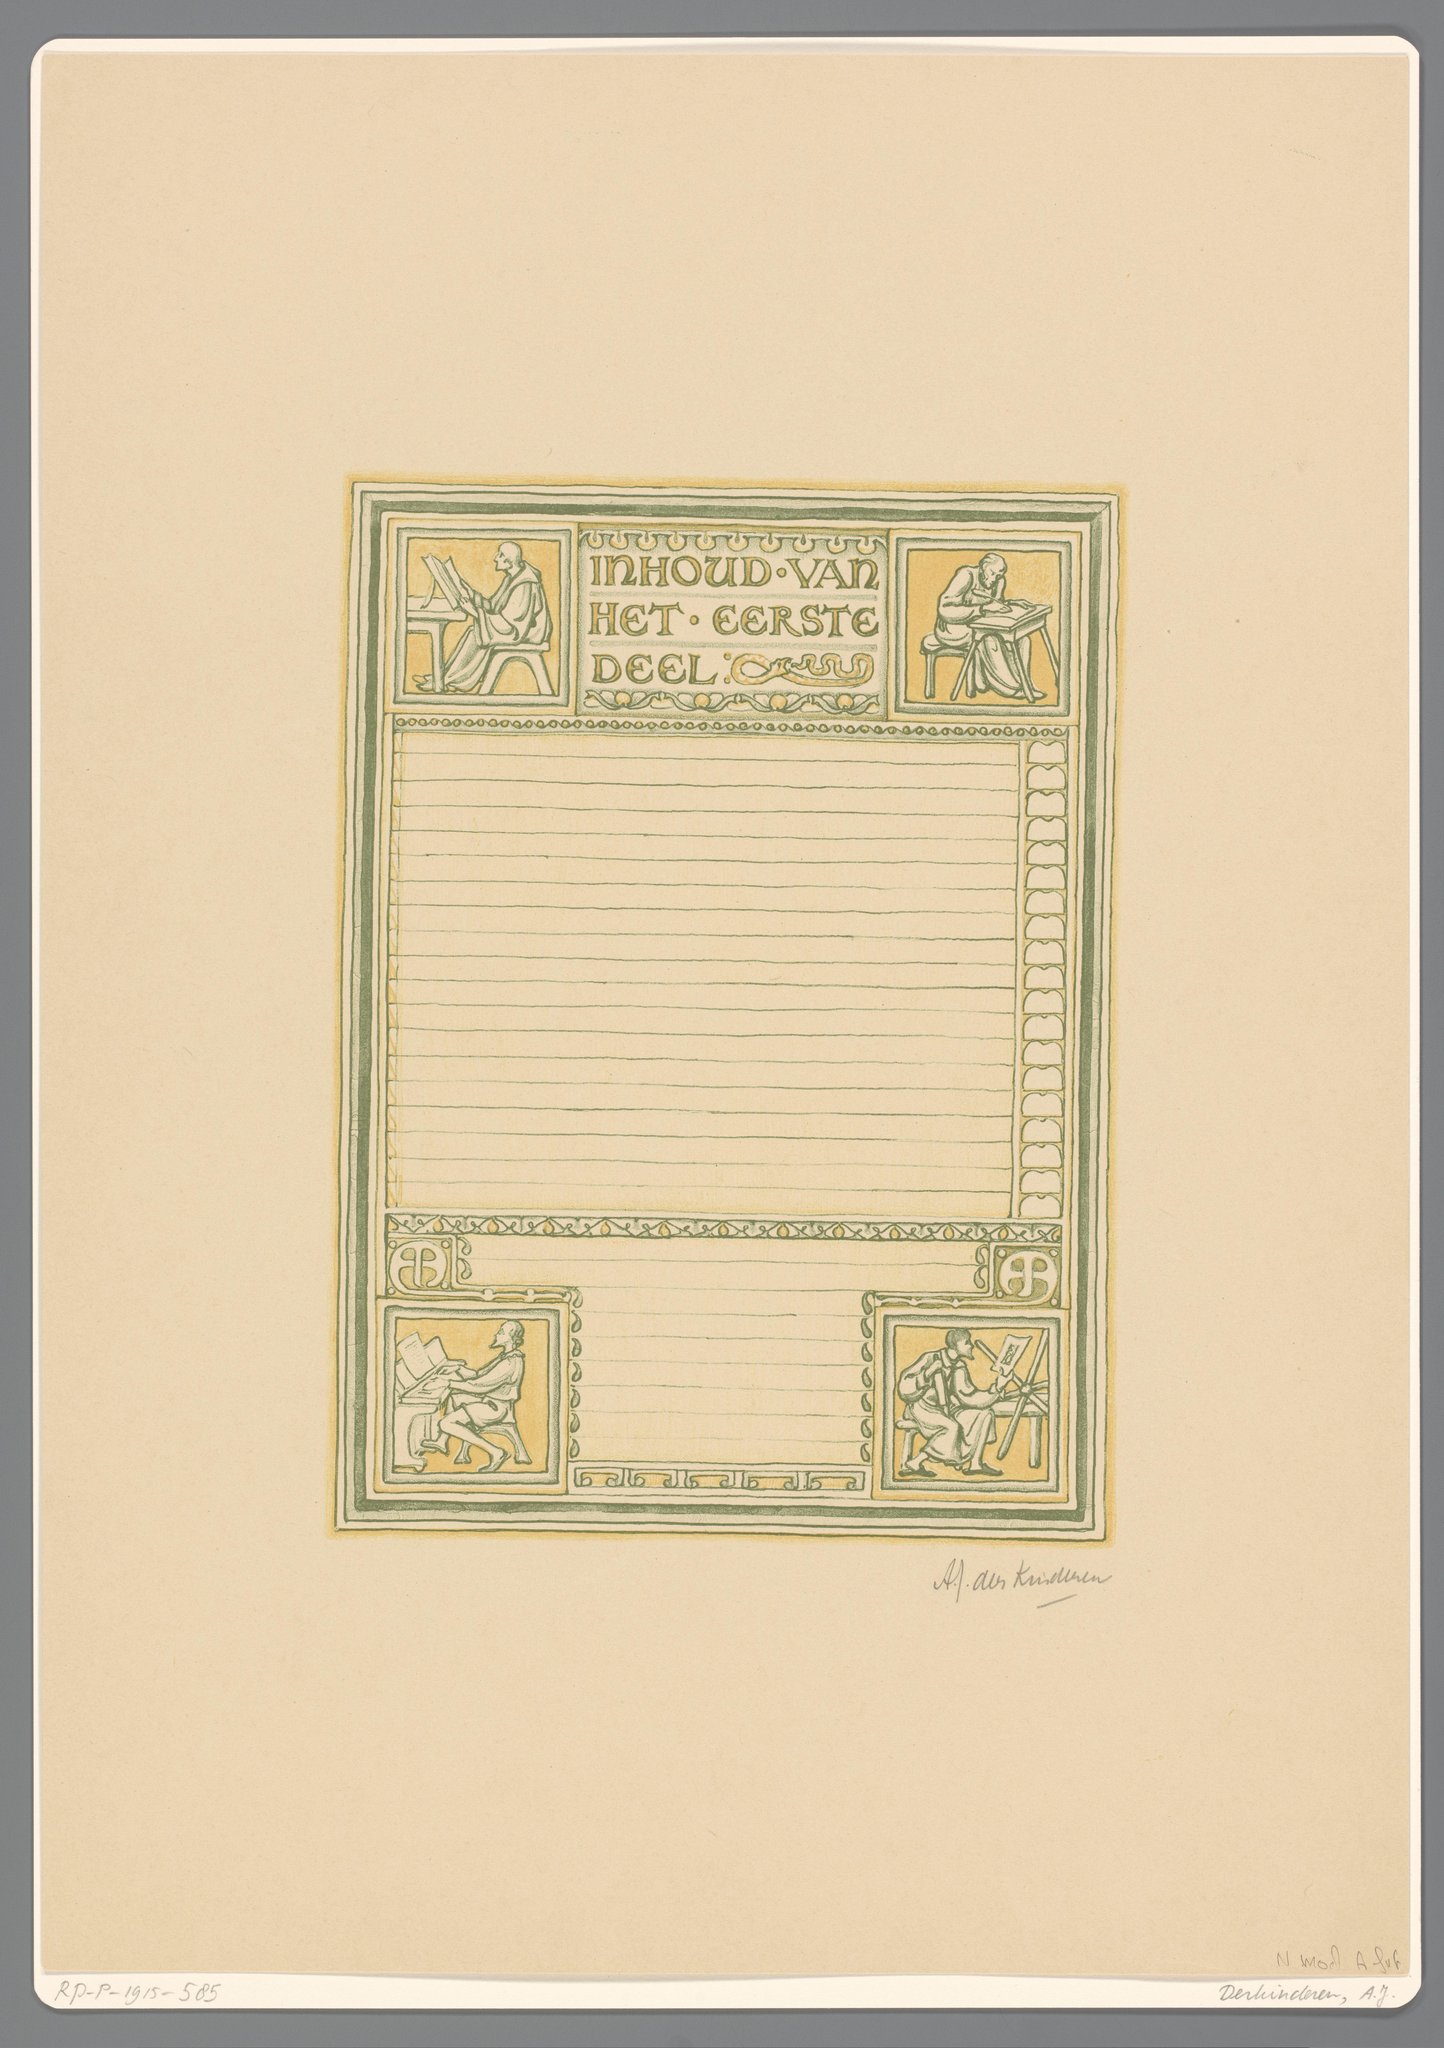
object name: book illustration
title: Inhoud van het eerste deel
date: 1894-1901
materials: paper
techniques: lithograph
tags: artist (in general)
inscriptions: collector's mark: Lugt 2233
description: Prent gebruikt voor: Vondel, Joost van den. Gysbreght van Aemstel. Haarlem: Erven F. Bohn, 1894-1901. De voorstelling is door Tresling & Comp. op steen overgebracht.